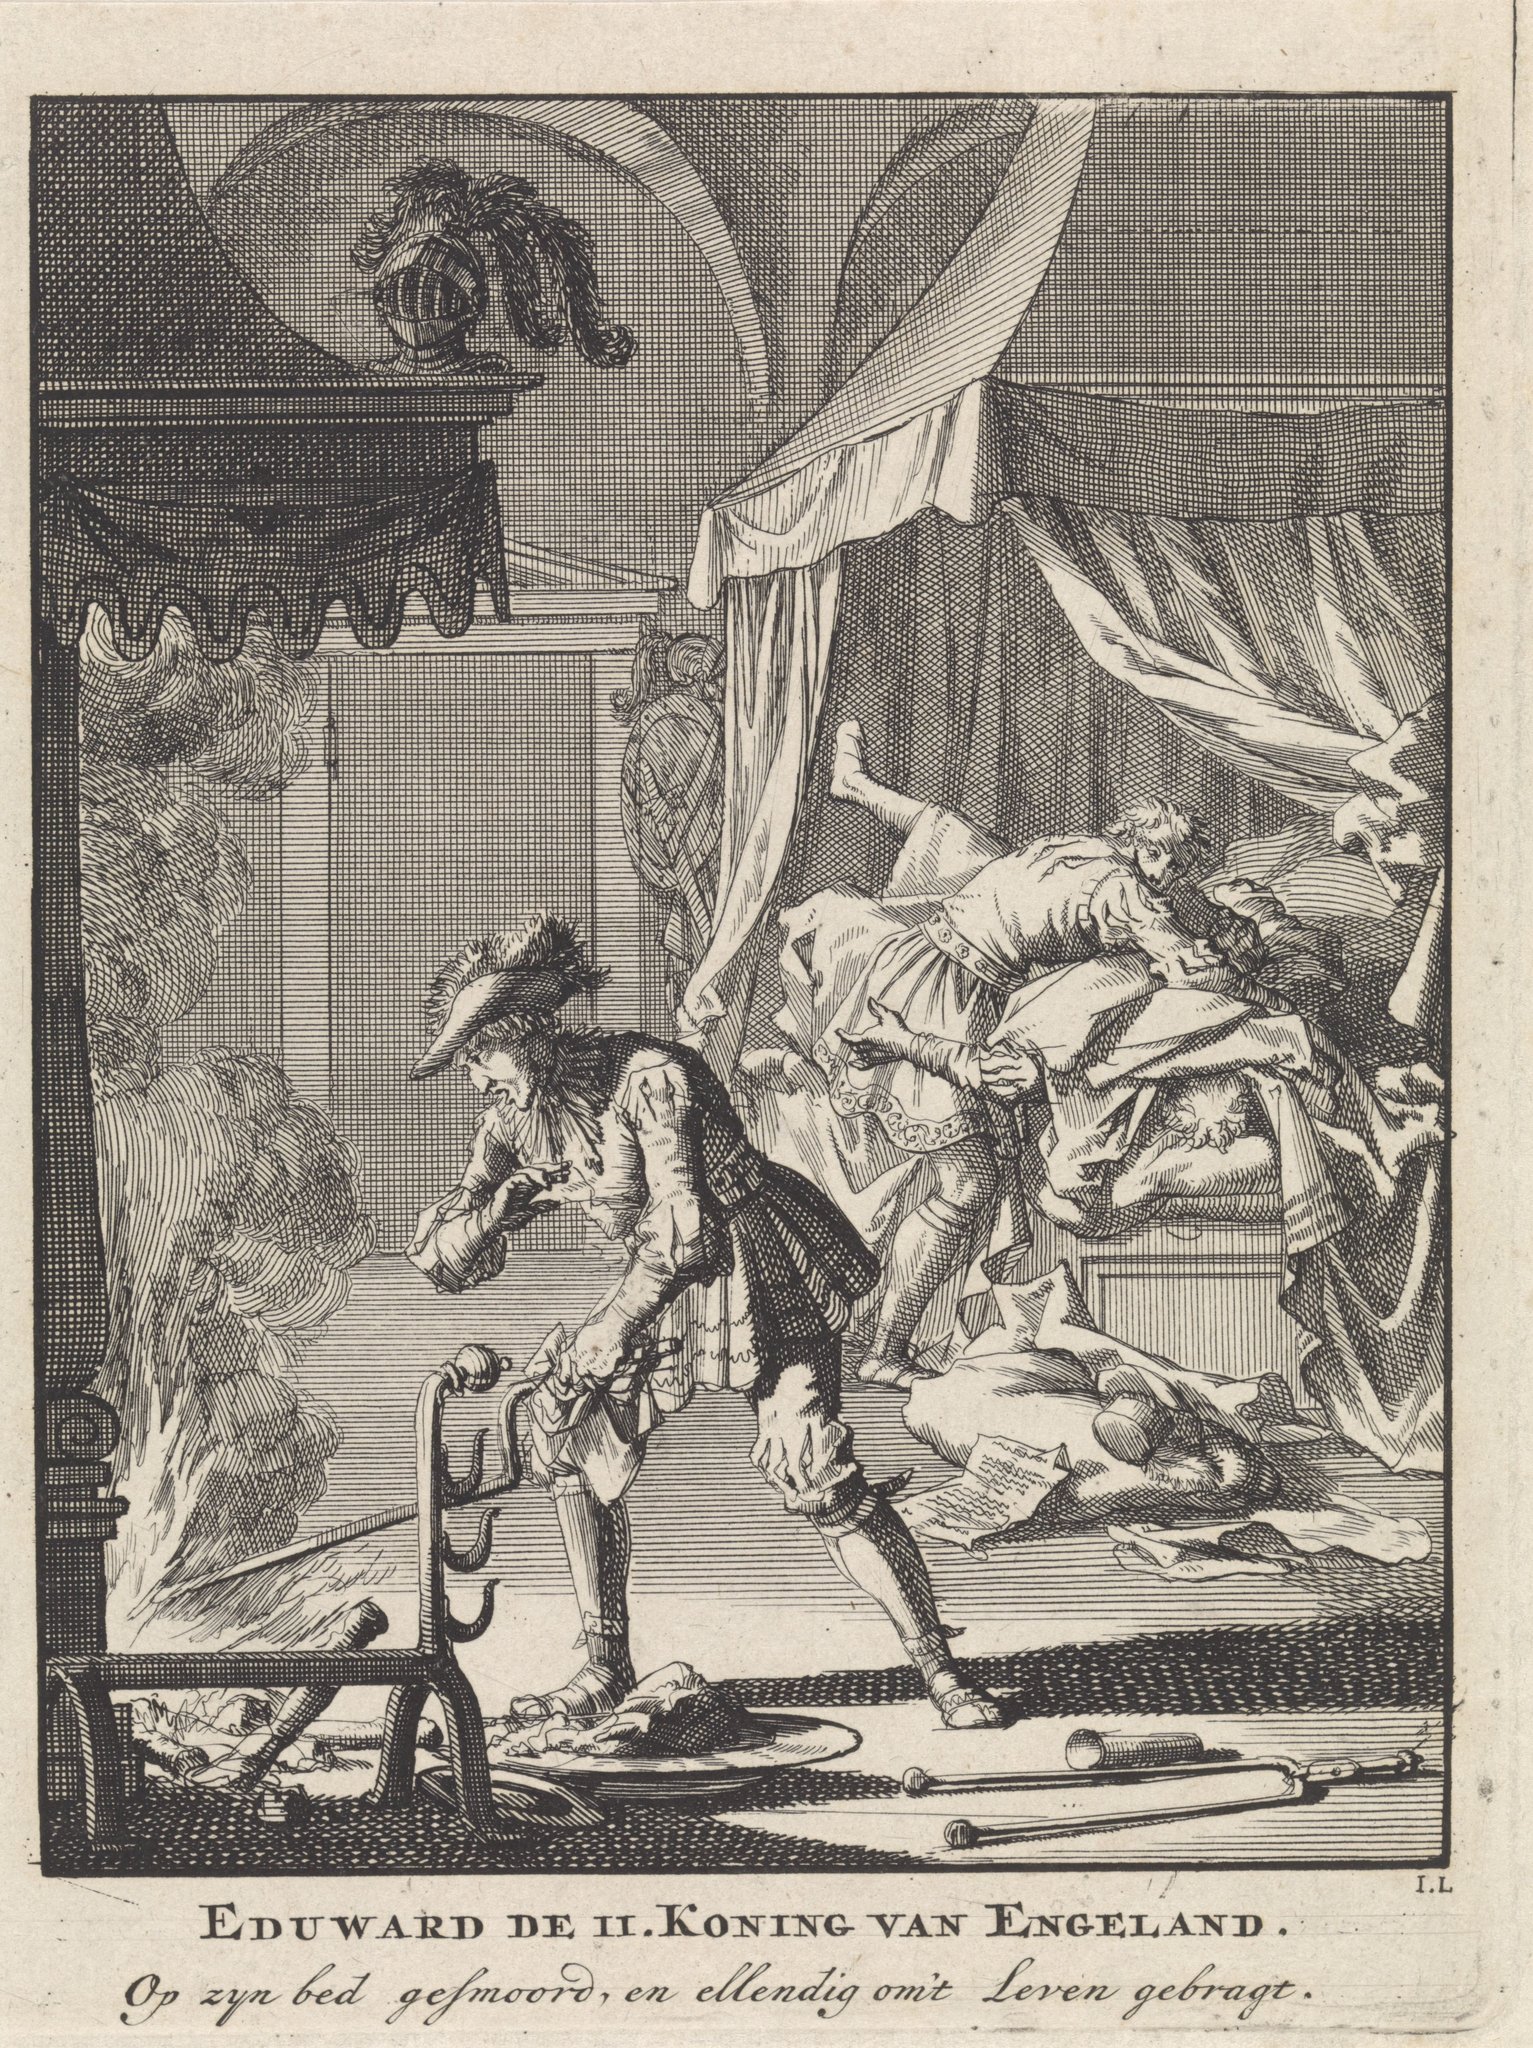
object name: print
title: Eduard II van Engeland vermoord in zijn slaapkamer, 1327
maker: jan luyken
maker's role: draughtsman, print maker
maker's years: 1649-1712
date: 1698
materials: paper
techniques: etching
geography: amsterdam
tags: attempt, political murder, bedroom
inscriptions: collector's mark: Lugt 2228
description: Proefdruk van illustratie uit: Bos, Lambert van den. Treur-toonneel der doorluchtige mannen, of Op- en ondergang der grooten, 3 delen. Amsterdam: Jan Claesz ten Hoorn, 1698, dl. I.